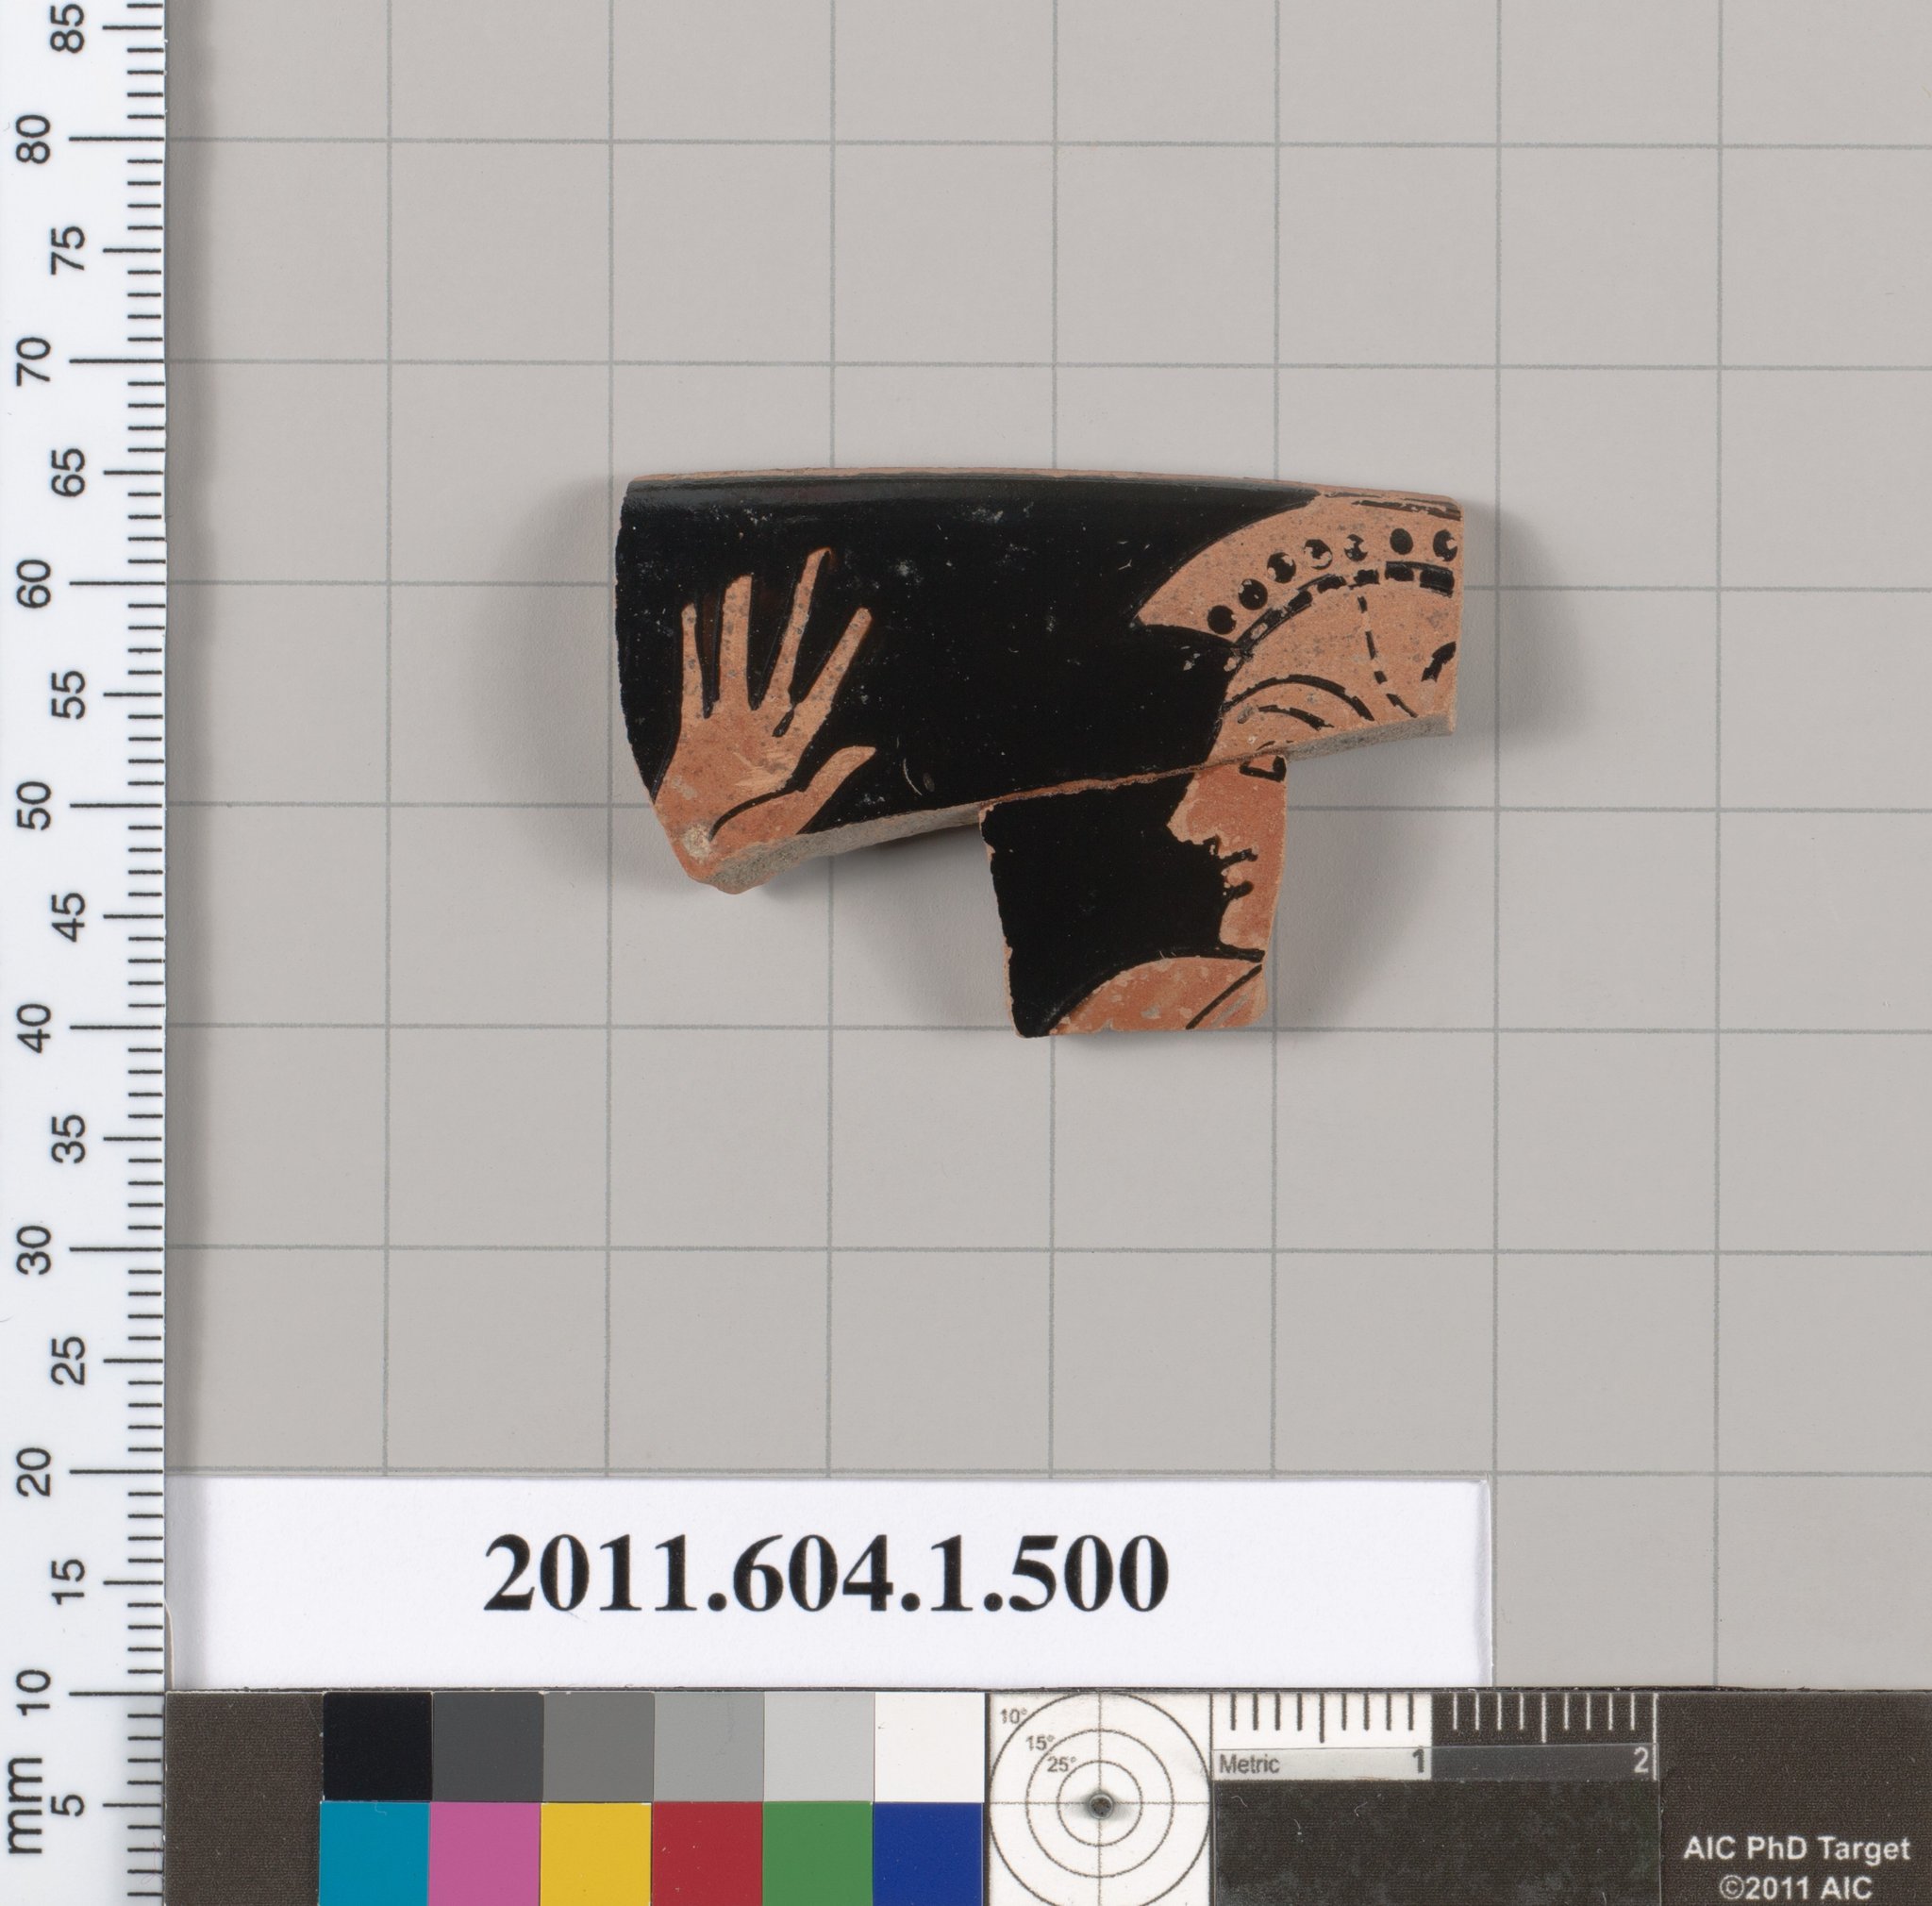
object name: kylix fragment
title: Terracotta rim fragment of a kylix (drinking cup)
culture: greek, attic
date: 534-501 BCE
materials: terracotta